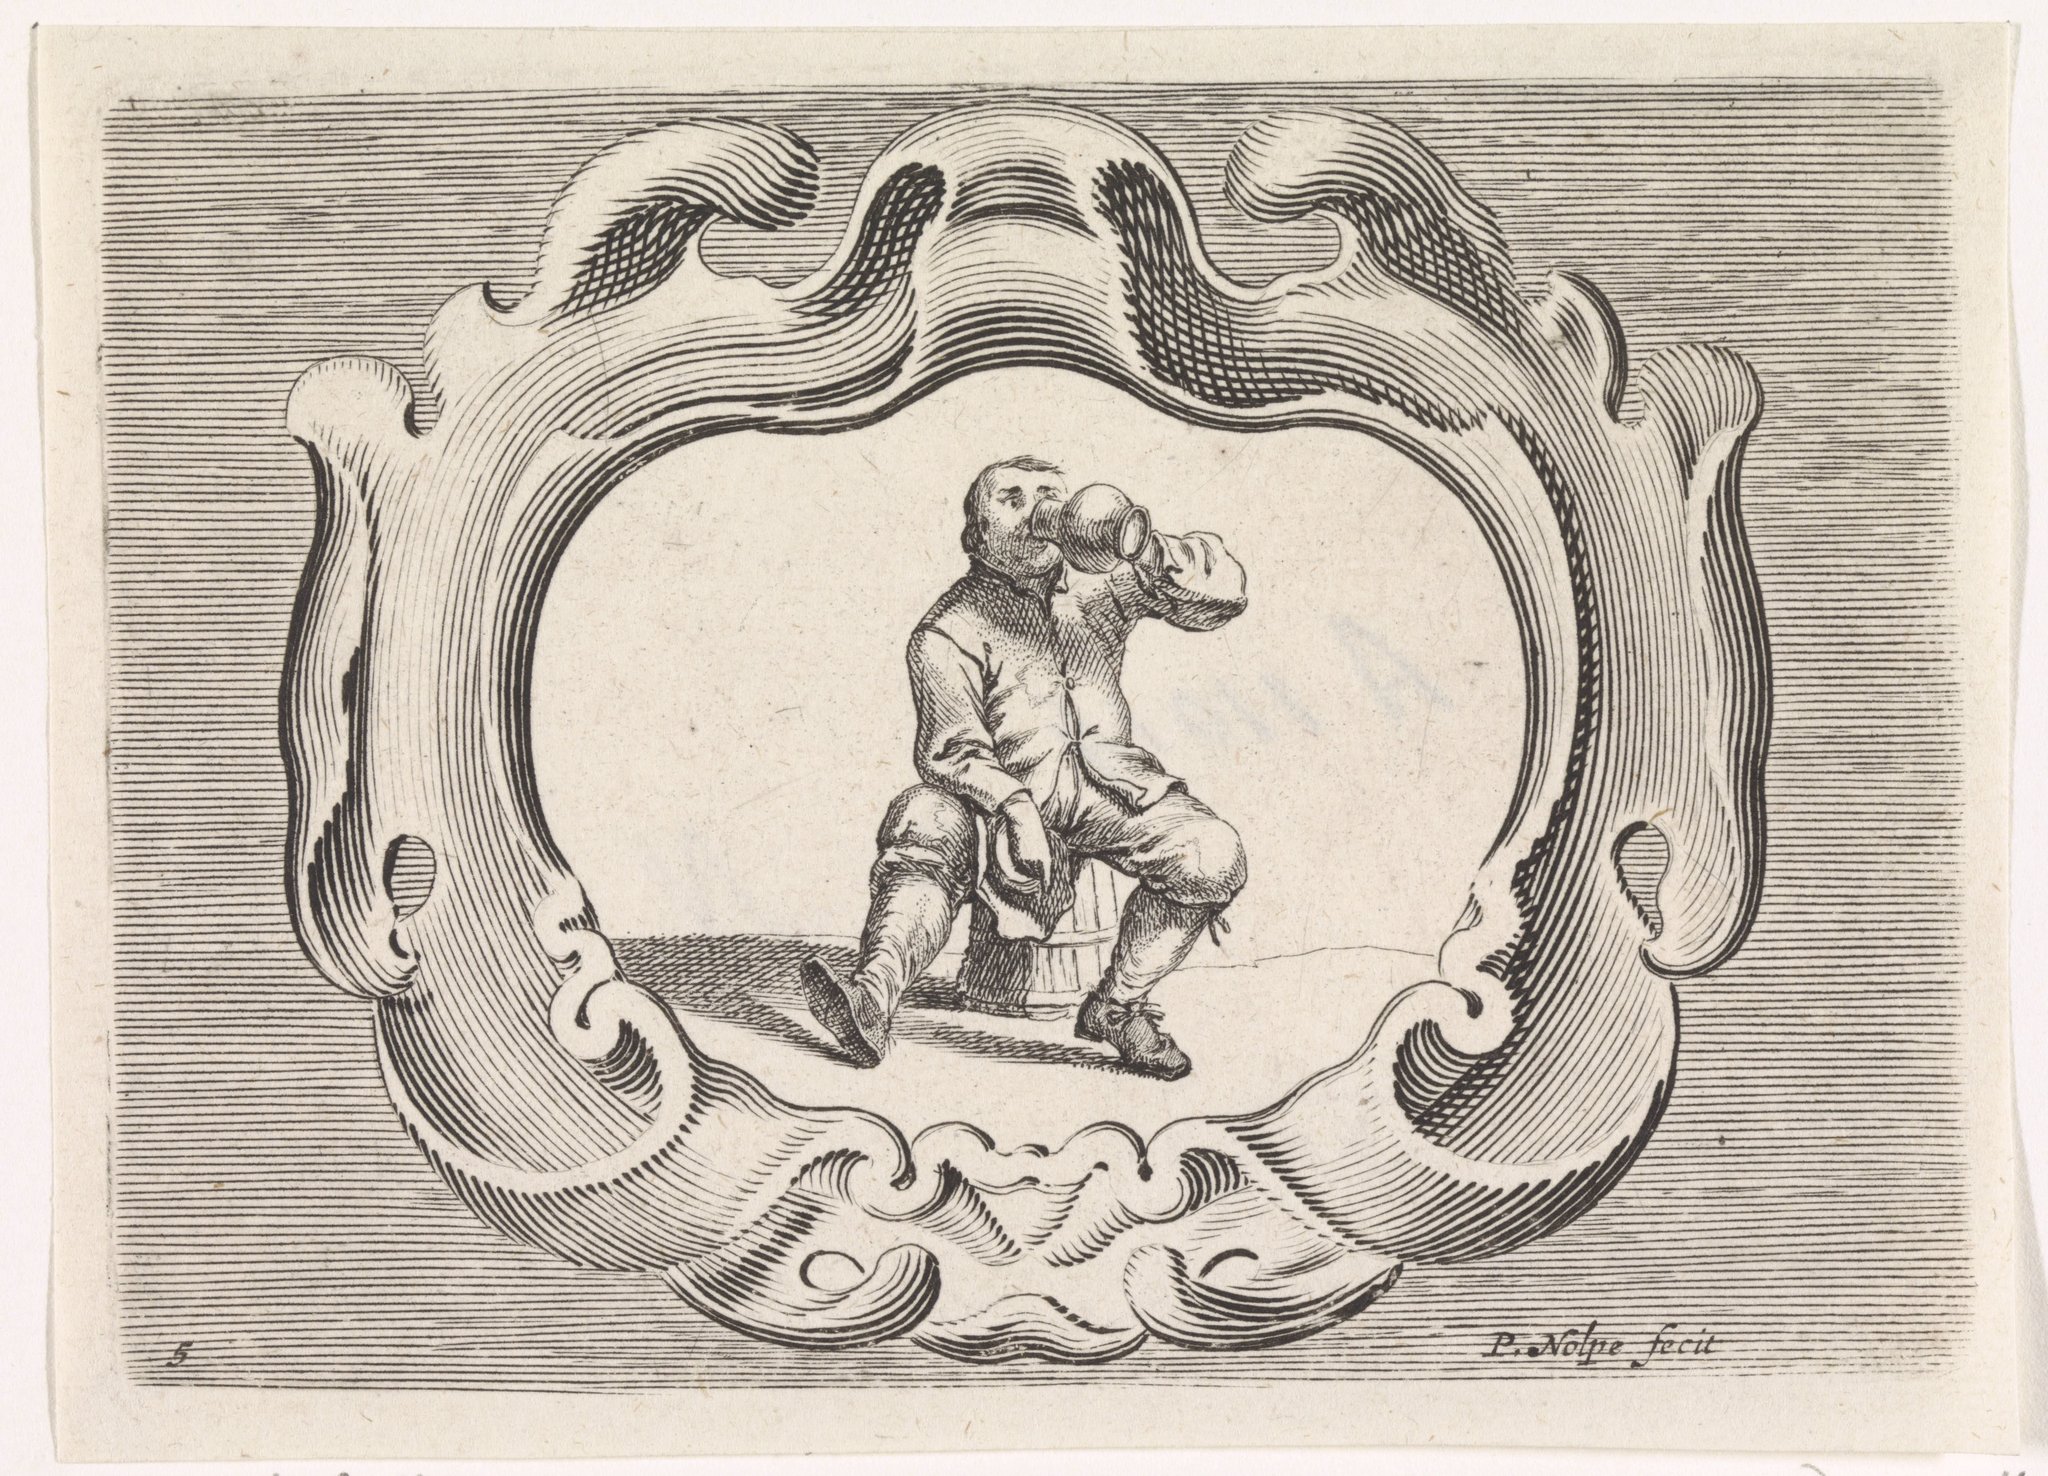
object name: print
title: Drinkende boer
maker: pieter nolpe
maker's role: draughtsman, print maker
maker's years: 1613-1653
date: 1623-1653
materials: paper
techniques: engraving, etching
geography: amsterdam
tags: jar, jug (used as drinking-vessel), farmers, drinking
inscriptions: collector's mark: Lugt 2228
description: Een boer, zittend op een houten emmer, drinkt uit een kruik. In zijn andere hand houdt hij zijn hoed. De voorstelling is gevat in een schulpvormig cartouche. Prent maakt deel uit van een serie met scènes uit het boerenleven.